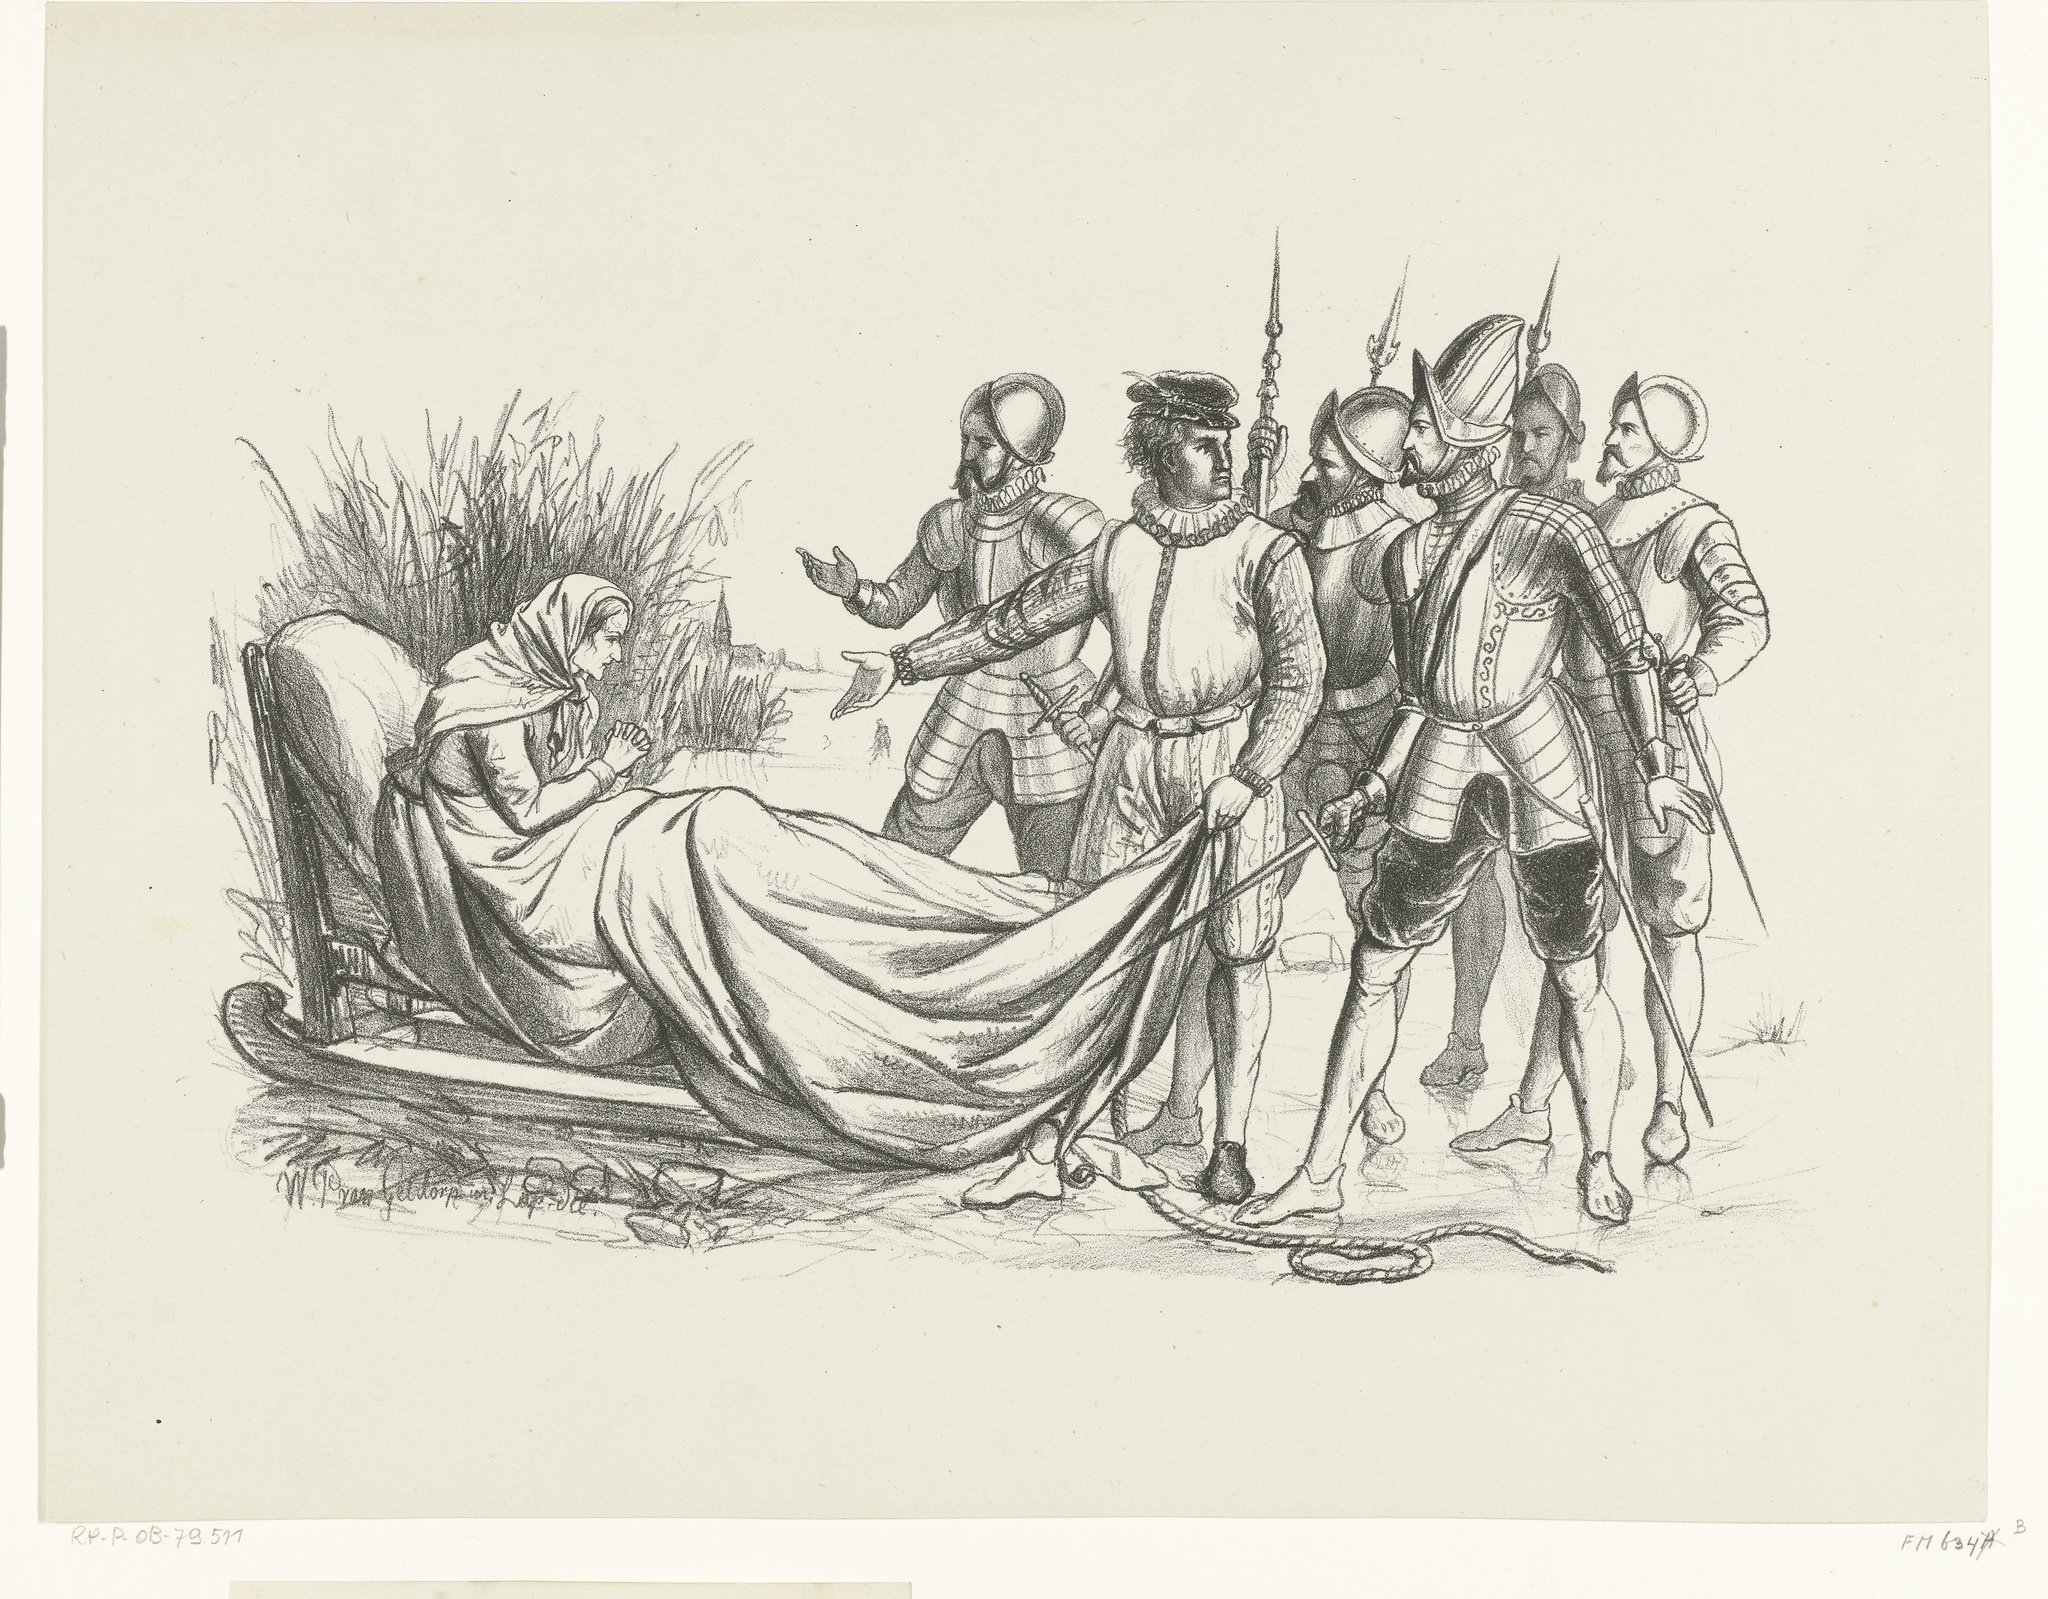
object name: print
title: Lambert Melisz. vlucht met zijn moeder in een slee over het ijs naar Hoorn, 1574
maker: wilhelmus petrus van geldorp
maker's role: print maker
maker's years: 1832-1900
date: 1842-1899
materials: paper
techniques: lithograph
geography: netherlands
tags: sleigh, sledge (non-sport)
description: Lambert Melisz. vlucht met zijn moeder in een slee over het ijs naar Hoorn, februari 1574. Lambert Melisz. toont de slee aan een groep van Spaanse soldaten.